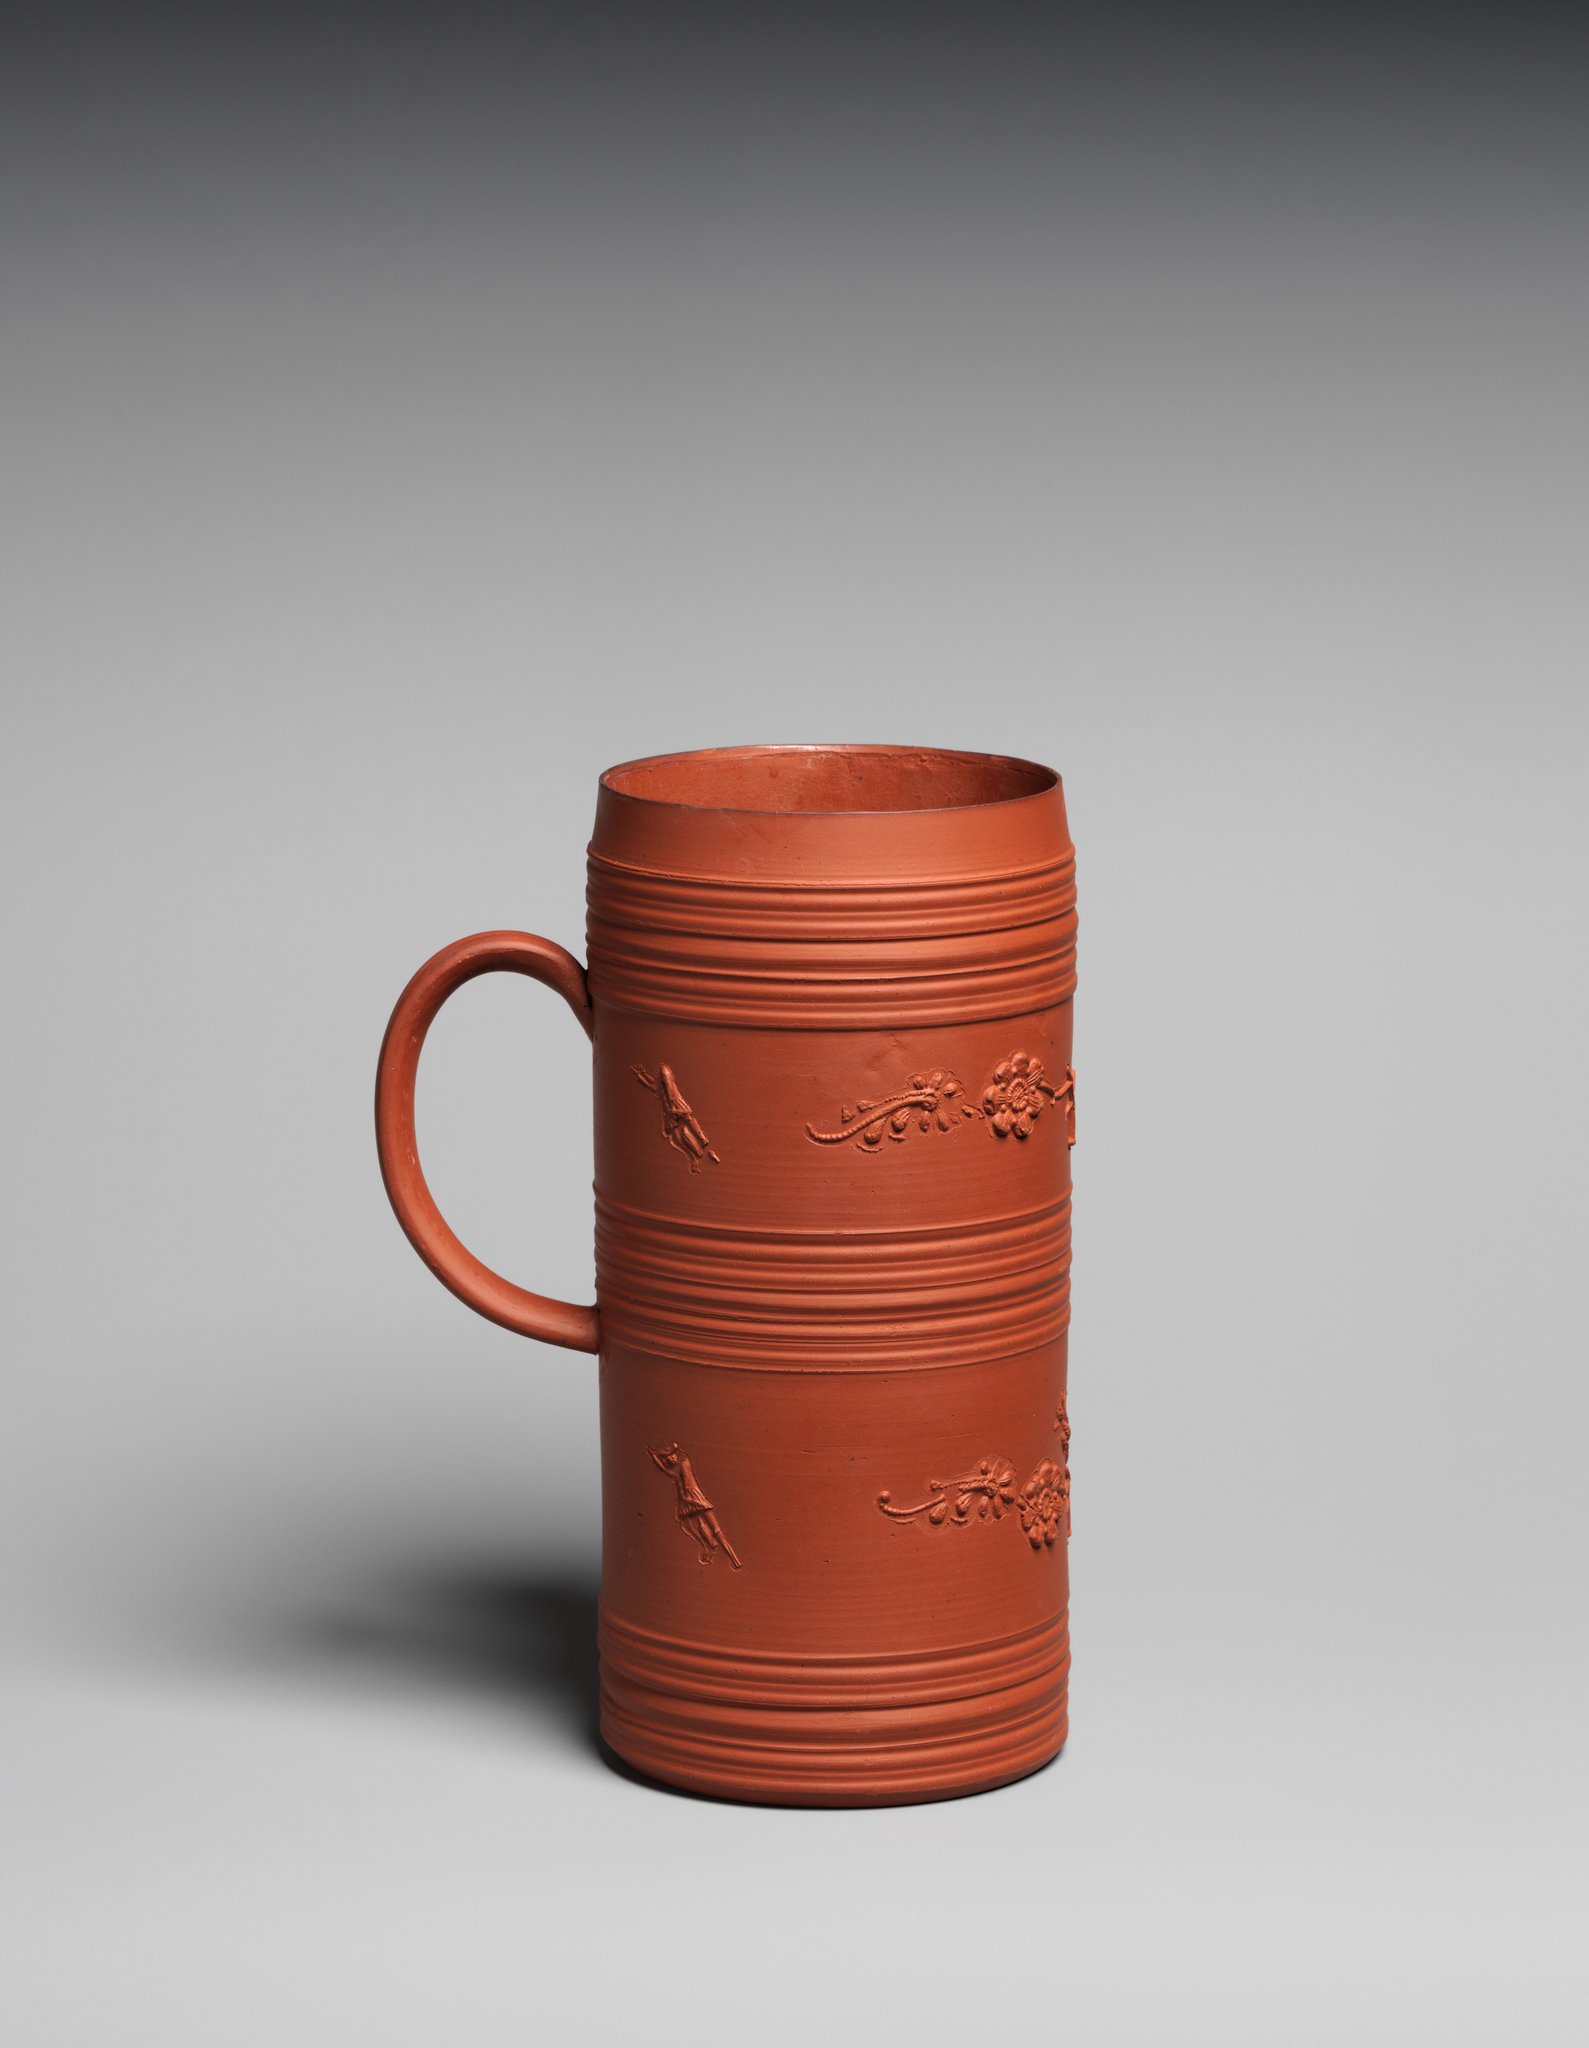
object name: mug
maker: david elers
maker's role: maker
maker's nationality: british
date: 1695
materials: earthenware